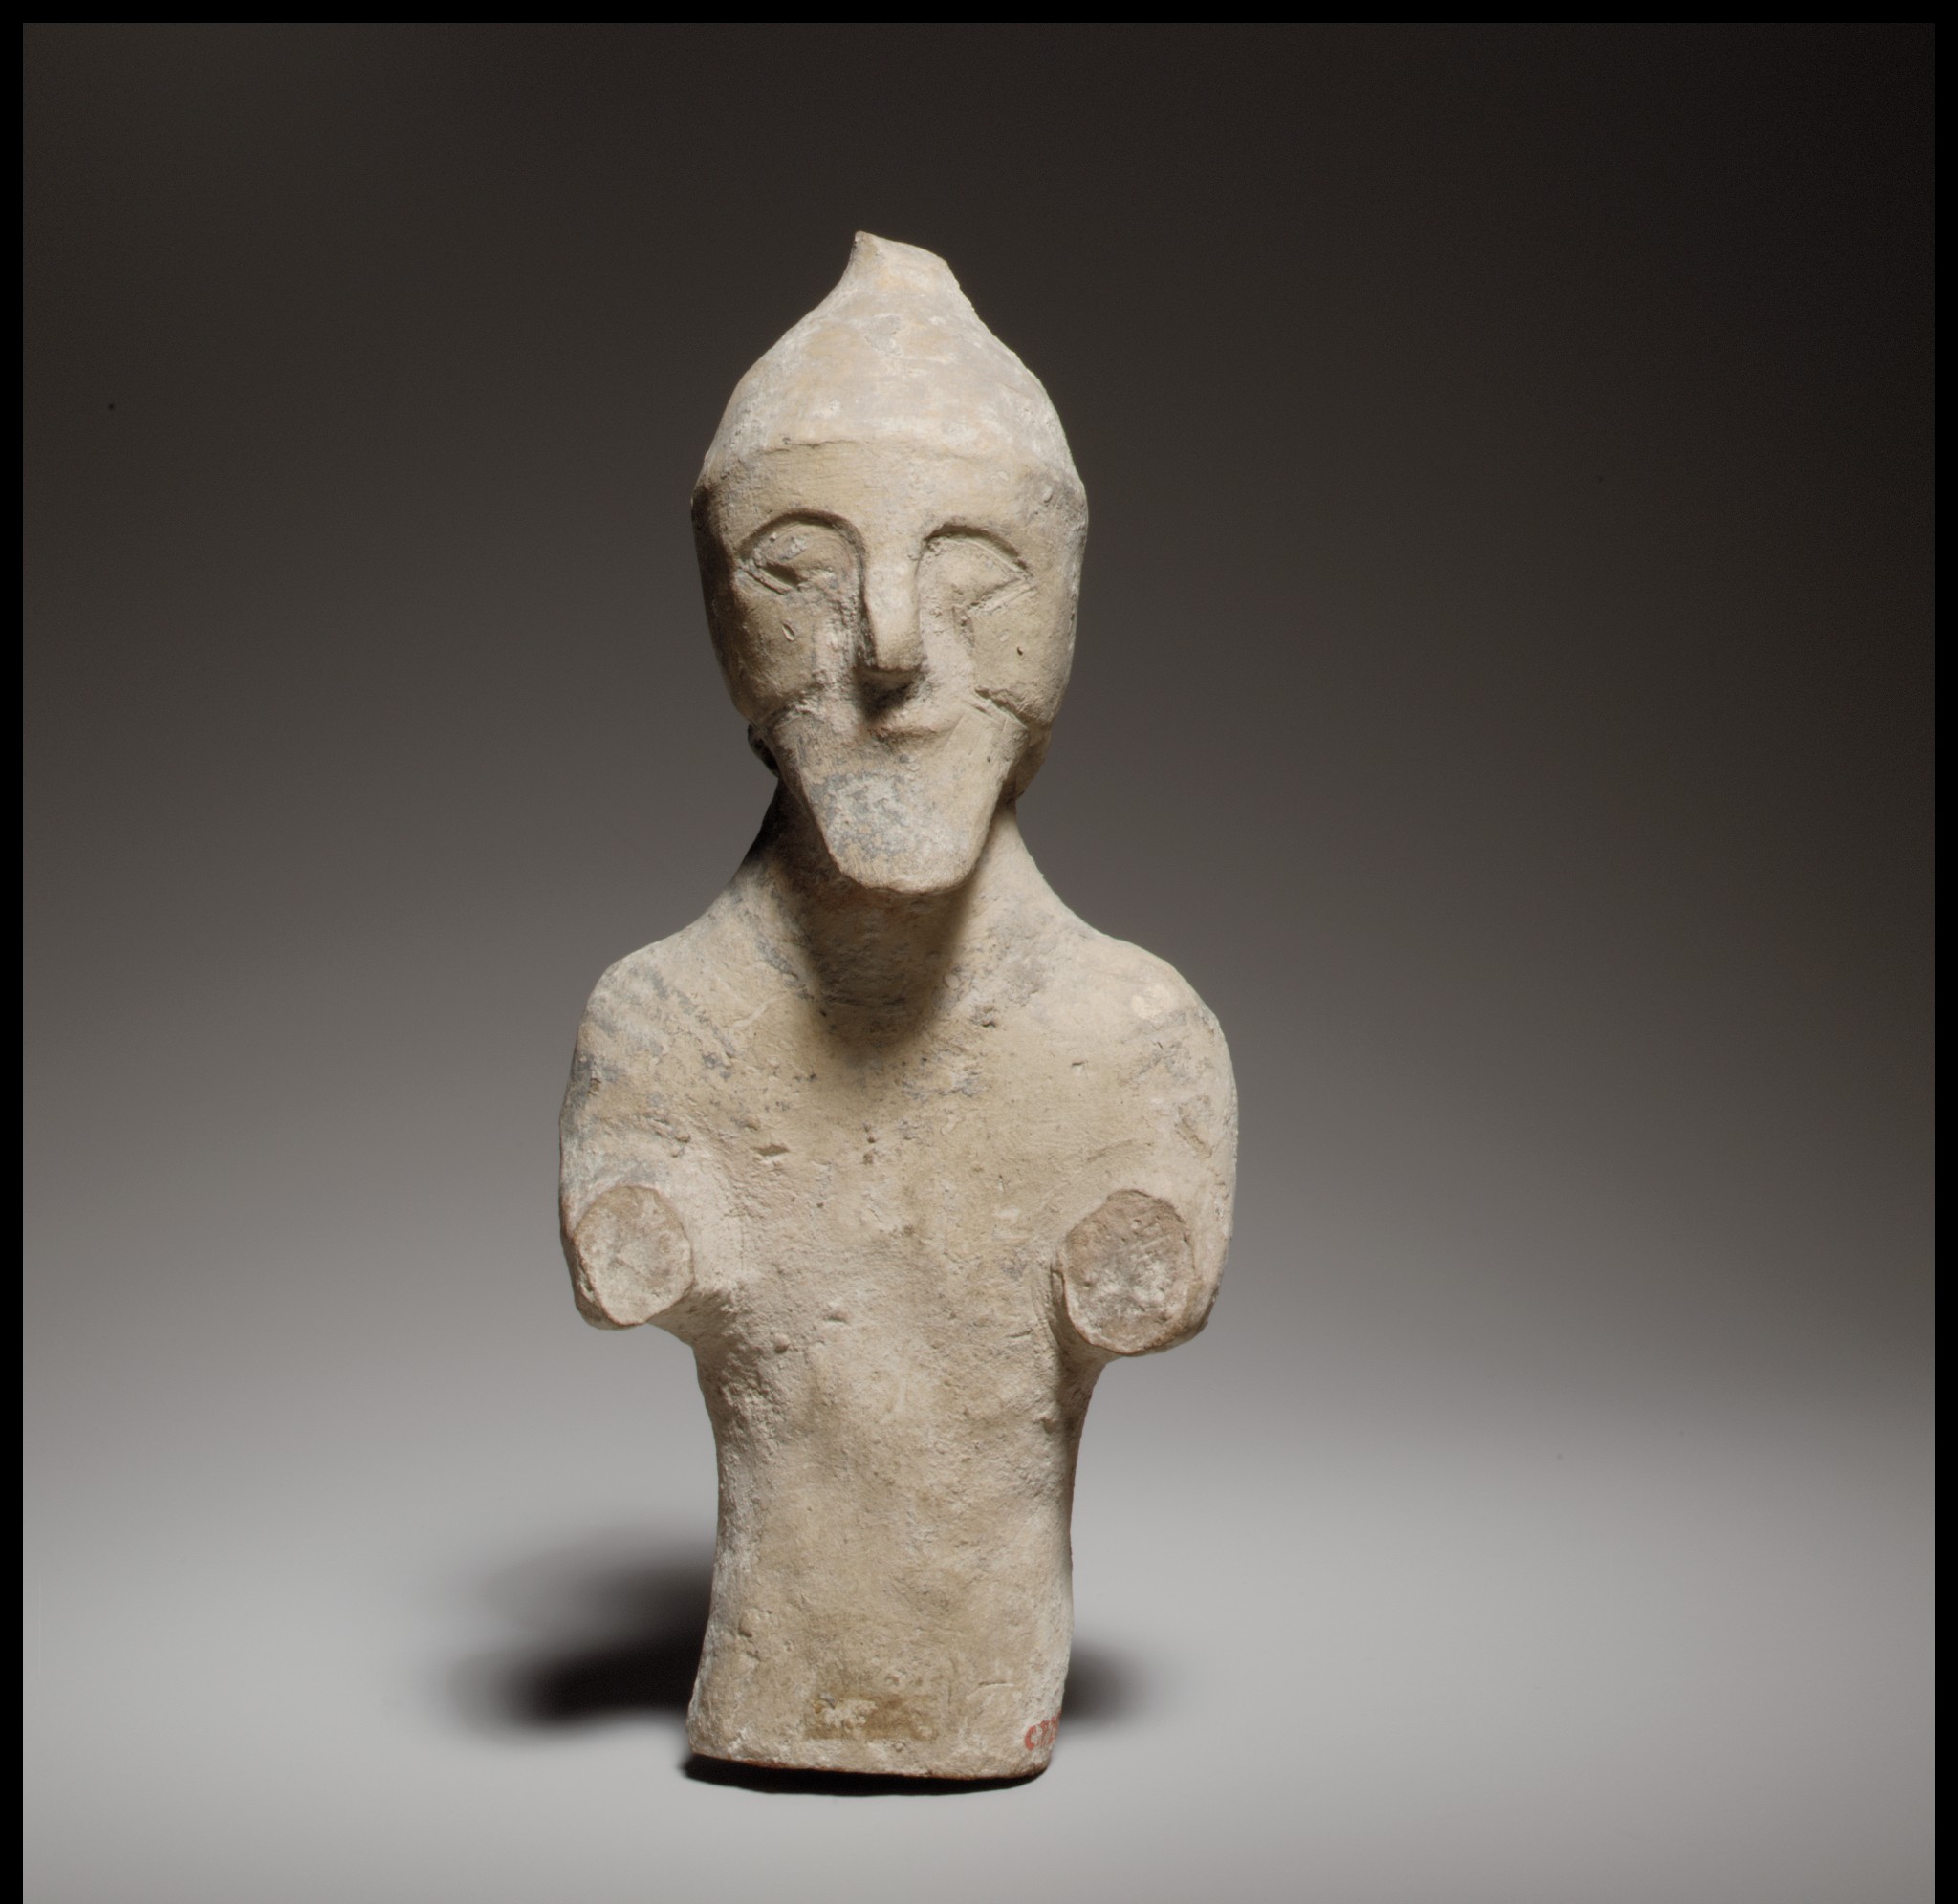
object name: statuette of a votary, male, with helmet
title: Charioteer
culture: cypriot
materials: terracotta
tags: men